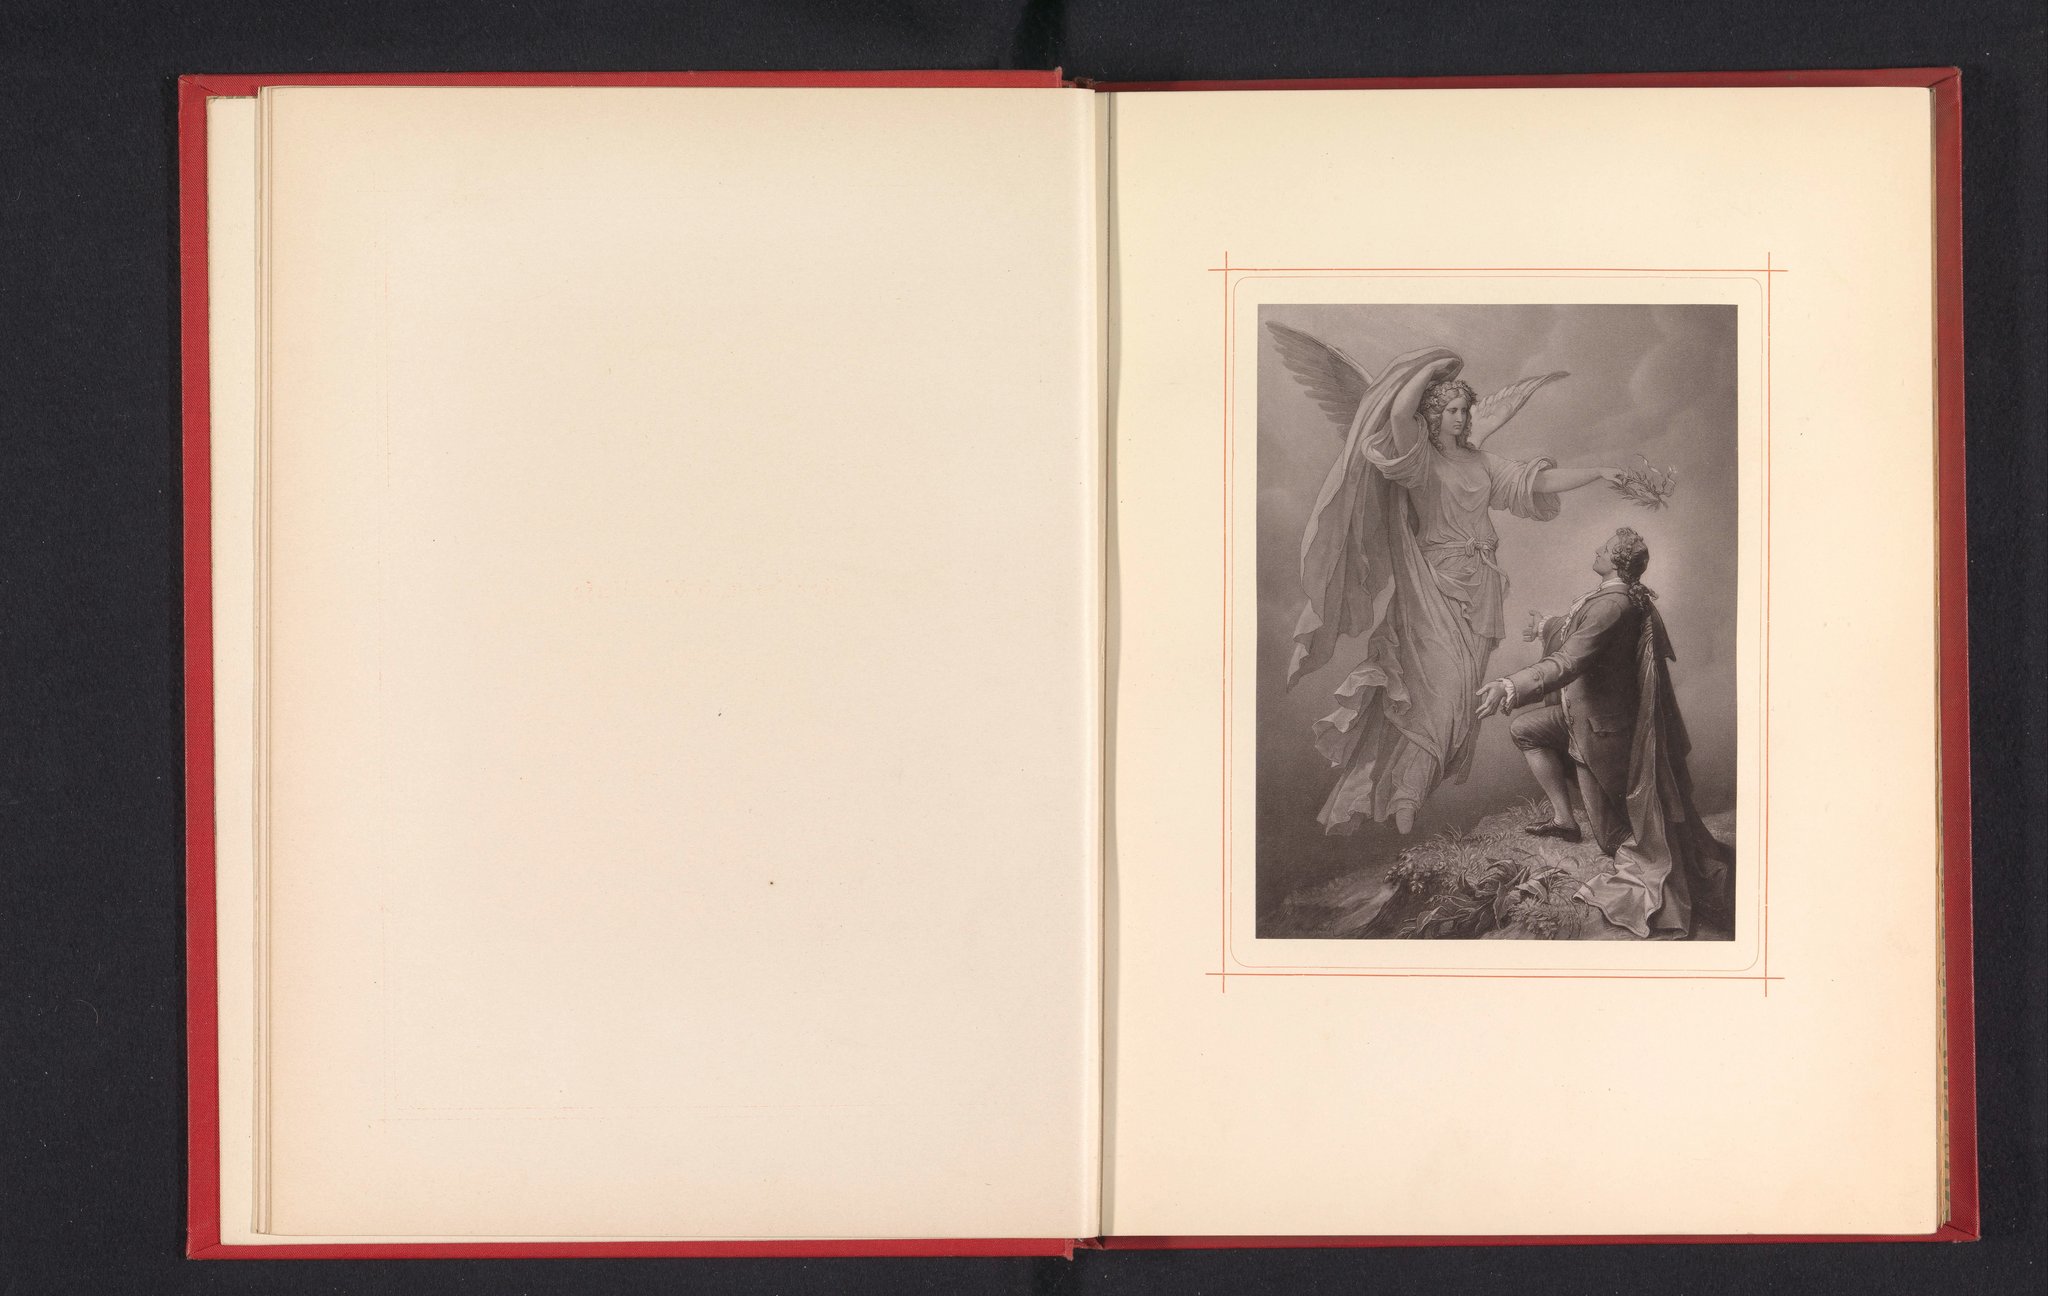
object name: photomechanical print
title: Fotoreproductie van een tekening, voorstellende Johann Wolfgang von Goethe wordt gelauwerd door zijn muze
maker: Anonymous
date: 1875-1880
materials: paper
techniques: photograph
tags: draughtsman, johann wolfgang von goethe, honouring the artist with laurel wreath, portrait of a writer, single muses